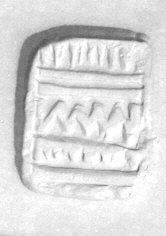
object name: stamp seal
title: Pyramidal seal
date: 3100-2900 BCE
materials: mineral, stone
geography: mesopotamia or syria